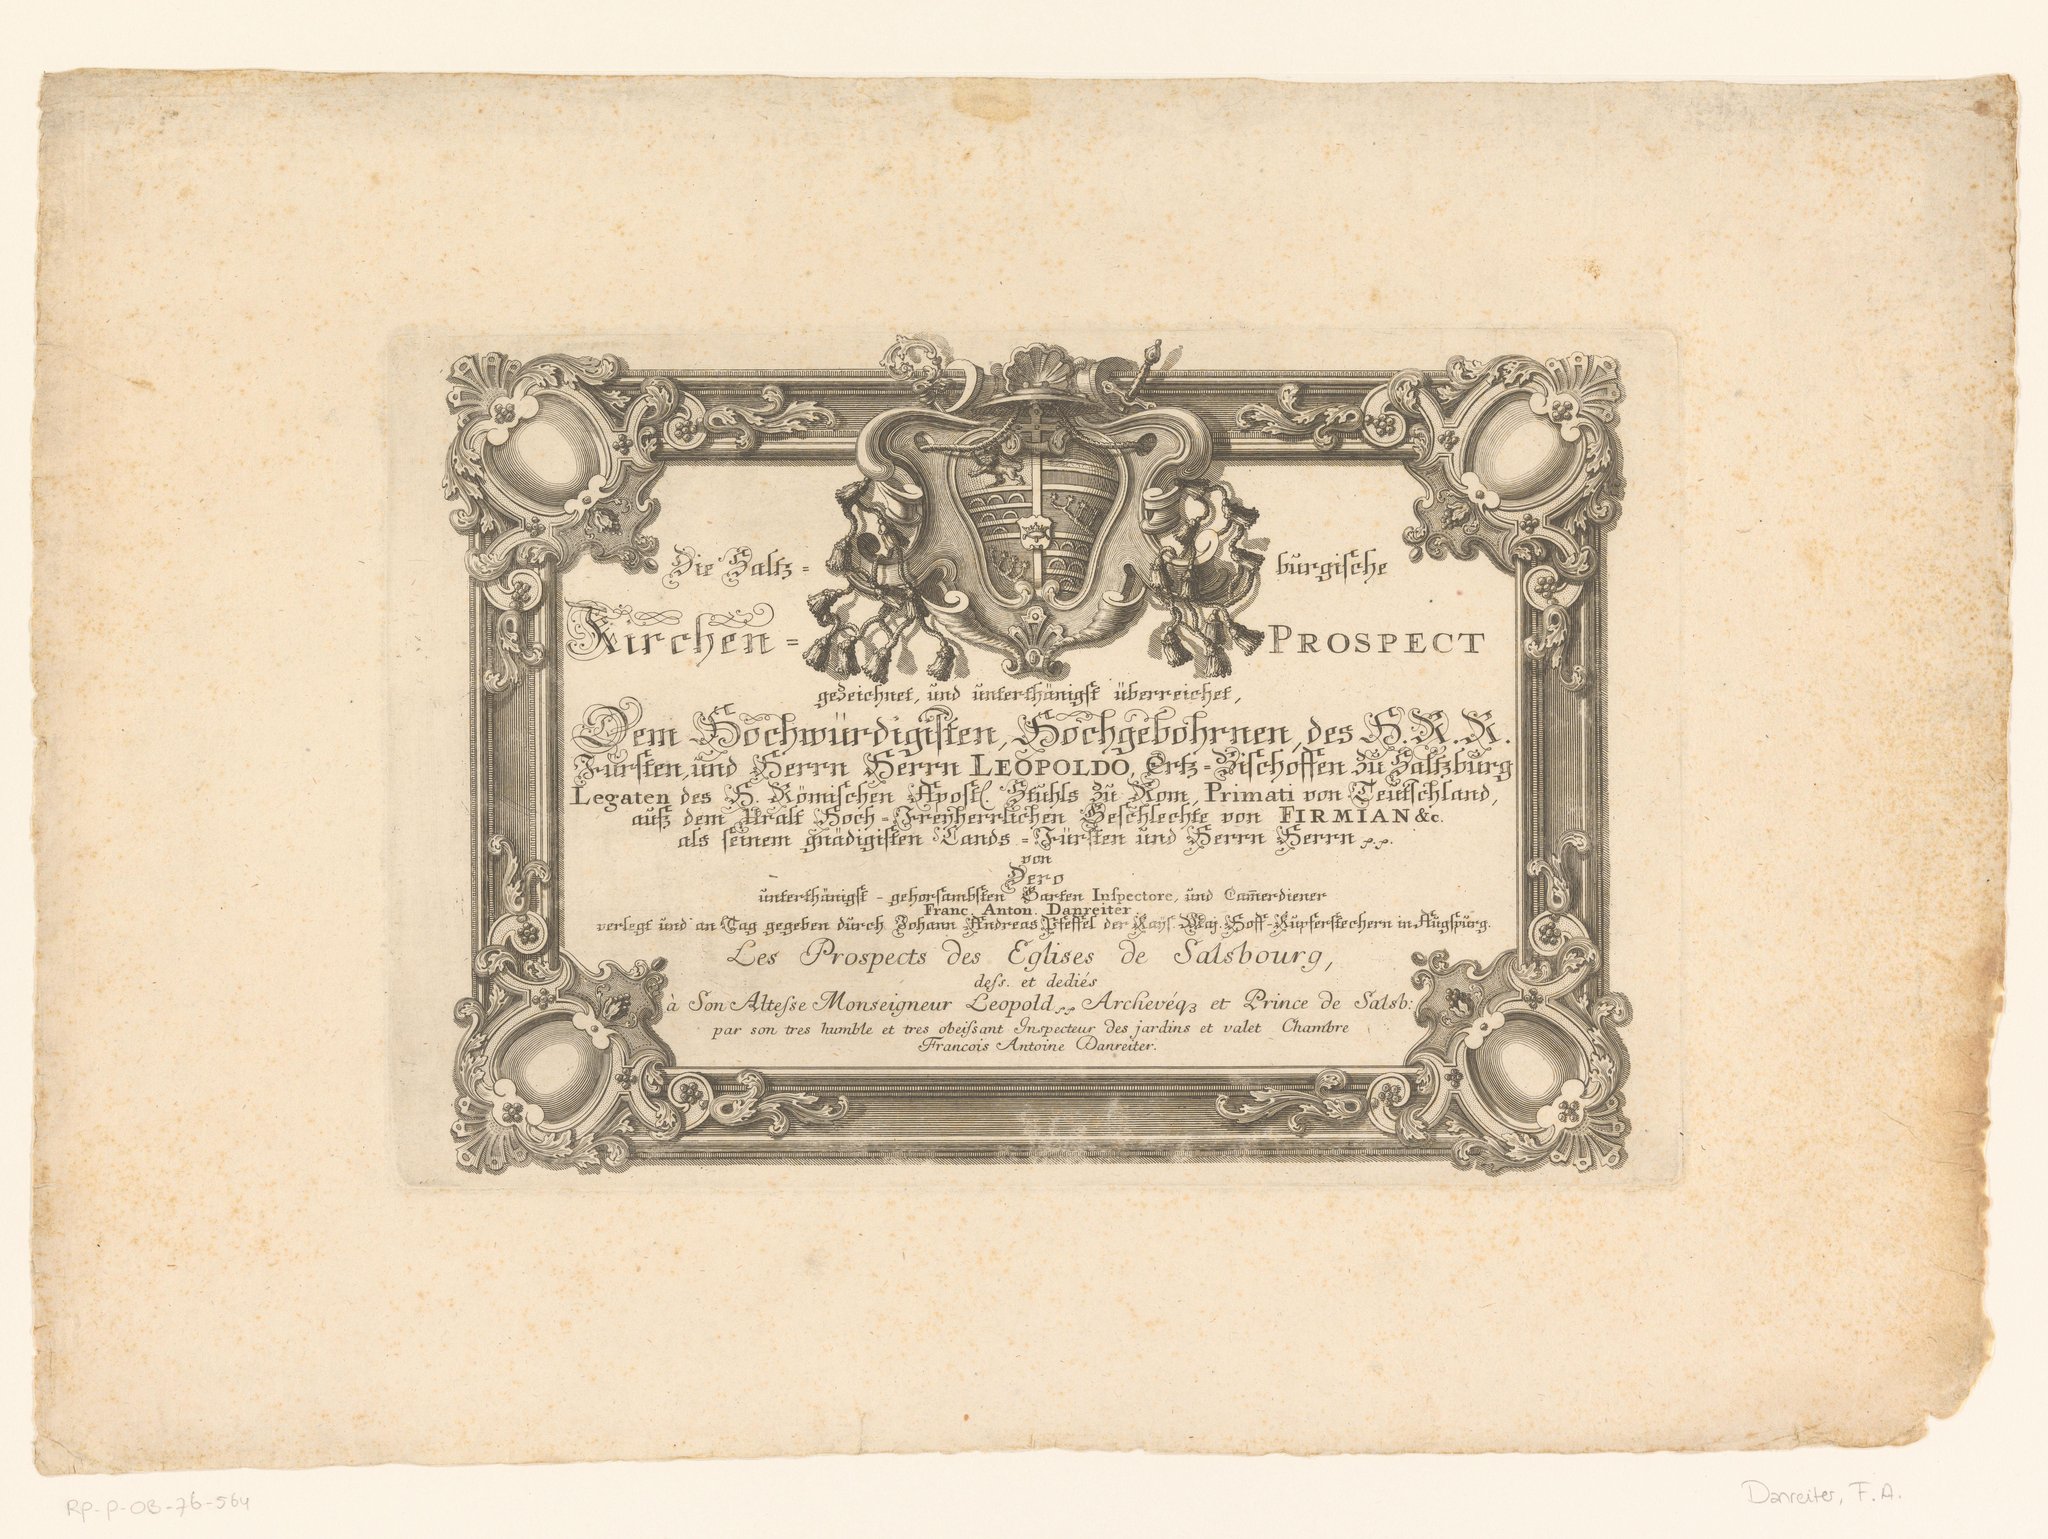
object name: print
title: Kerkgebouwen in Salzburg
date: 1730-1740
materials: paper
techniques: engraving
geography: augsburg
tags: ornaments ~ art (+ framing decorations), ornament ~ cartouche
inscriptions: collector's mark: Lugt 2228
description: Een rechthoekige omlijsting met in de hoeken rocaille cartouches. Midden boven een rocaille cartouche met wapenschild met een bisschopsstaf en zwaard. In de omlijsting de serietitel.